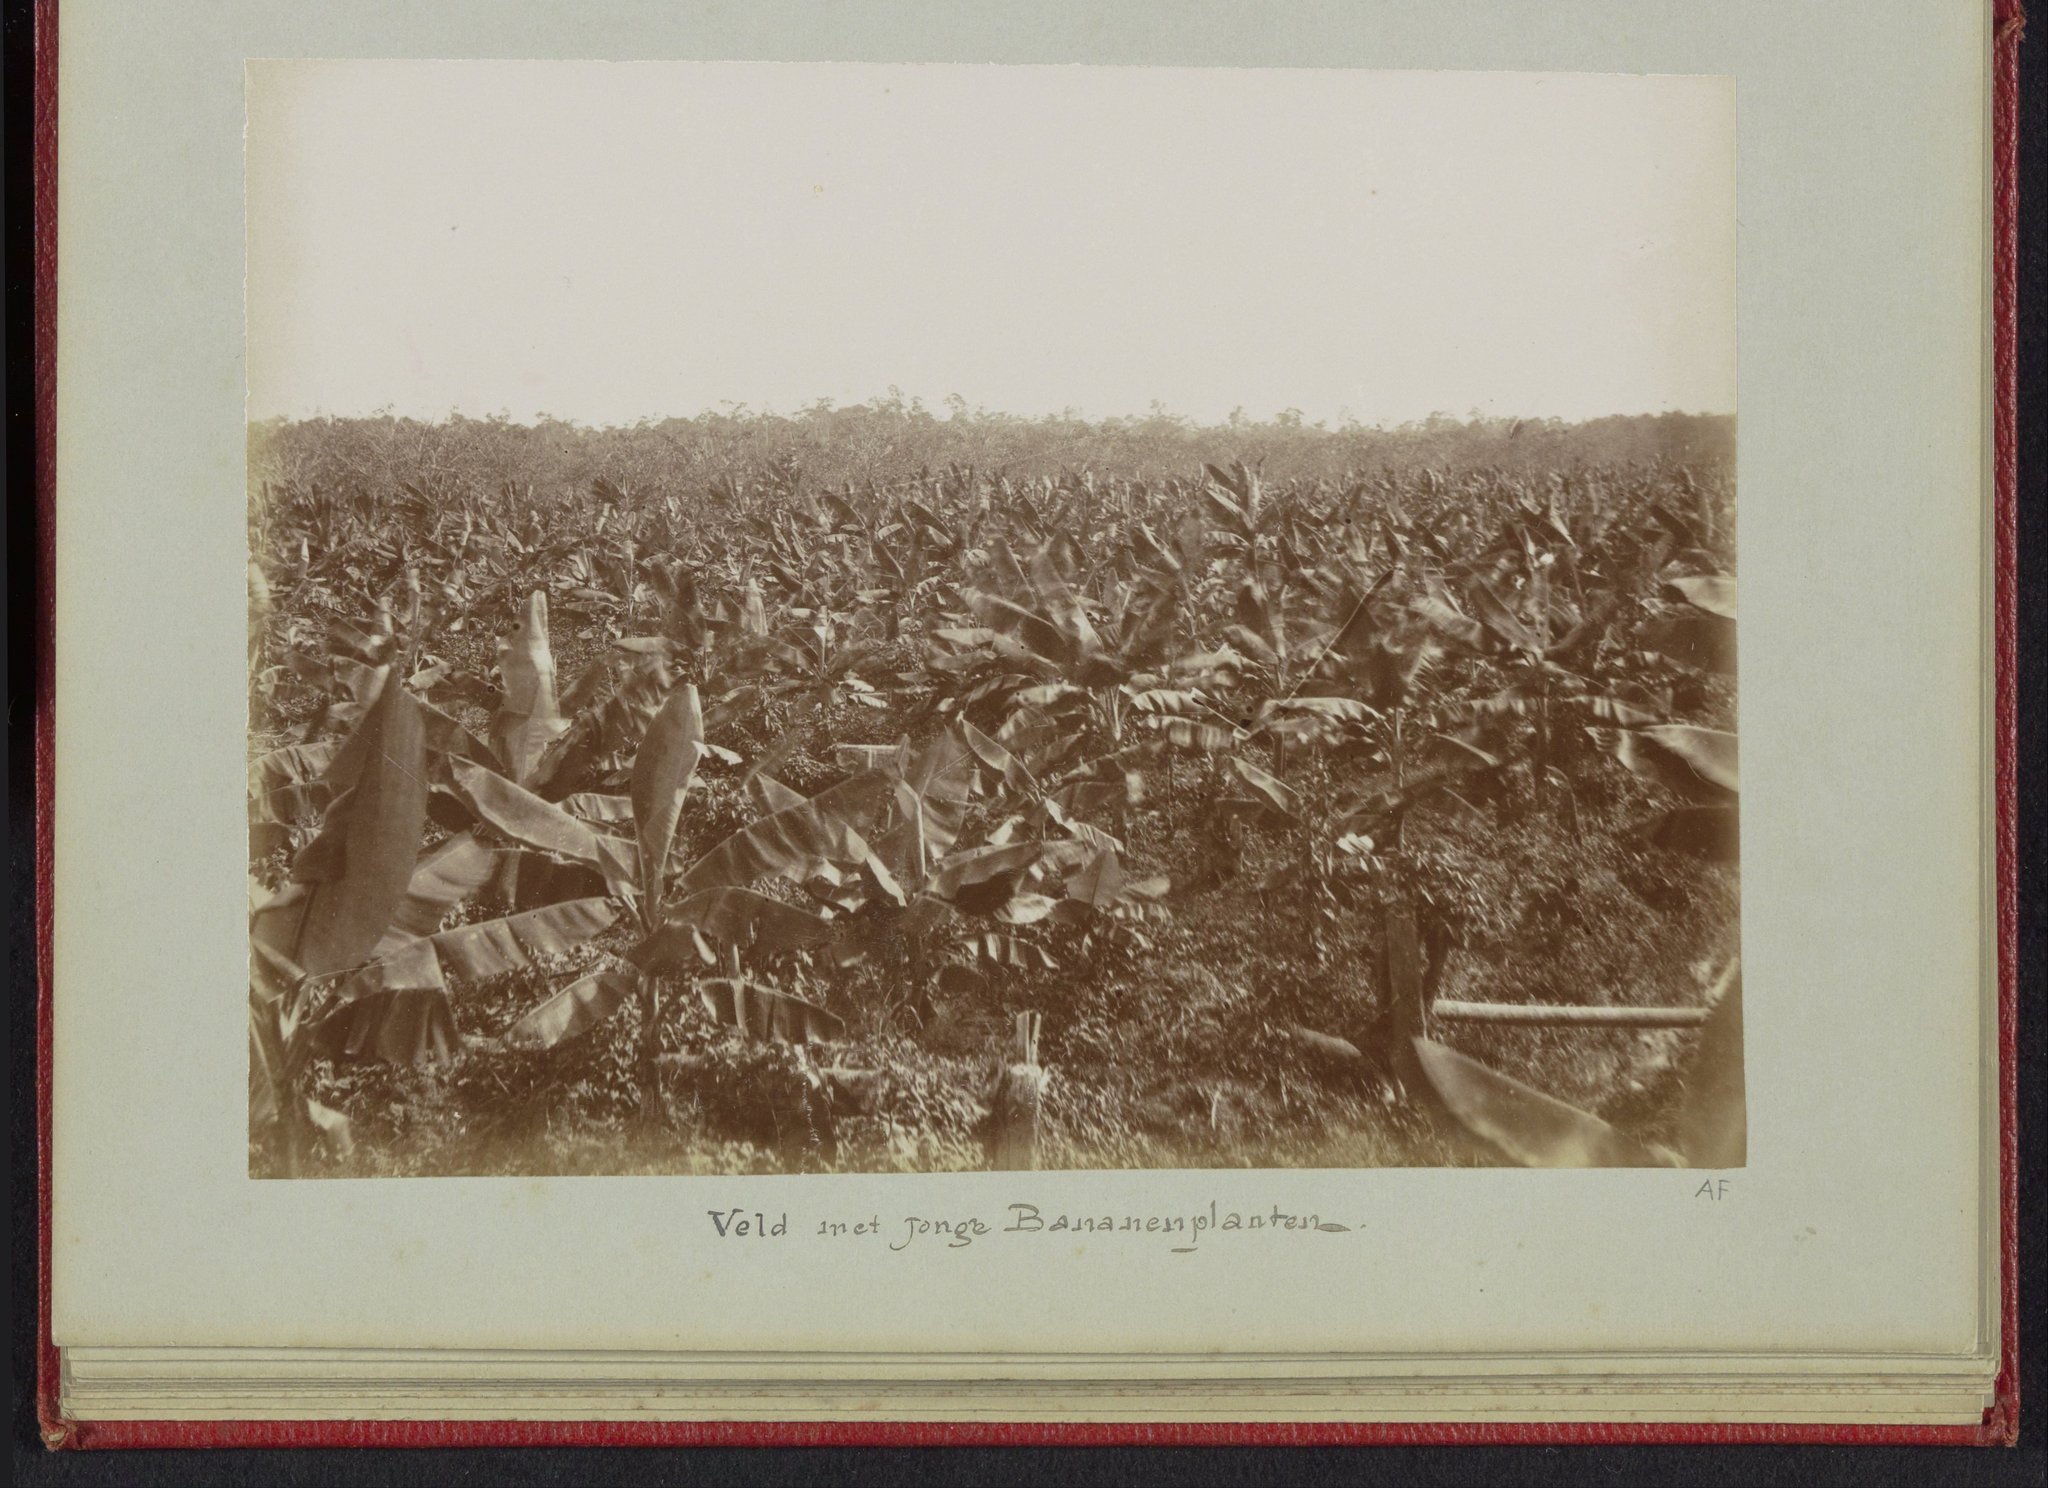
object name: photograph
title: Veld met jonge bananenplanten in Suriname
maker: Anonymous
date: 1890-1900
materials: photographic support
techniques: albumen print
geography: suriname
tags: plantation, field filled with a crop, suriname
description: Onderdeel van Fotoalbum met opnames van bezienswaardigheden in Europa, Trinidad, Haïti, Martinique en Suriname.